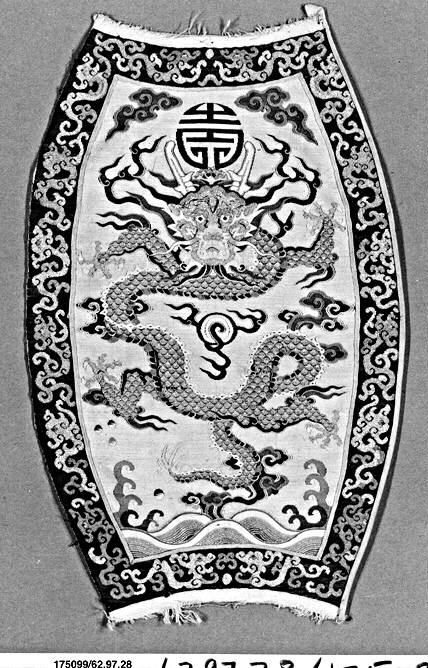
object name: panel for elbow pillow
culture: chinese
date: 1723-1735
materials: silk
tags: dragons